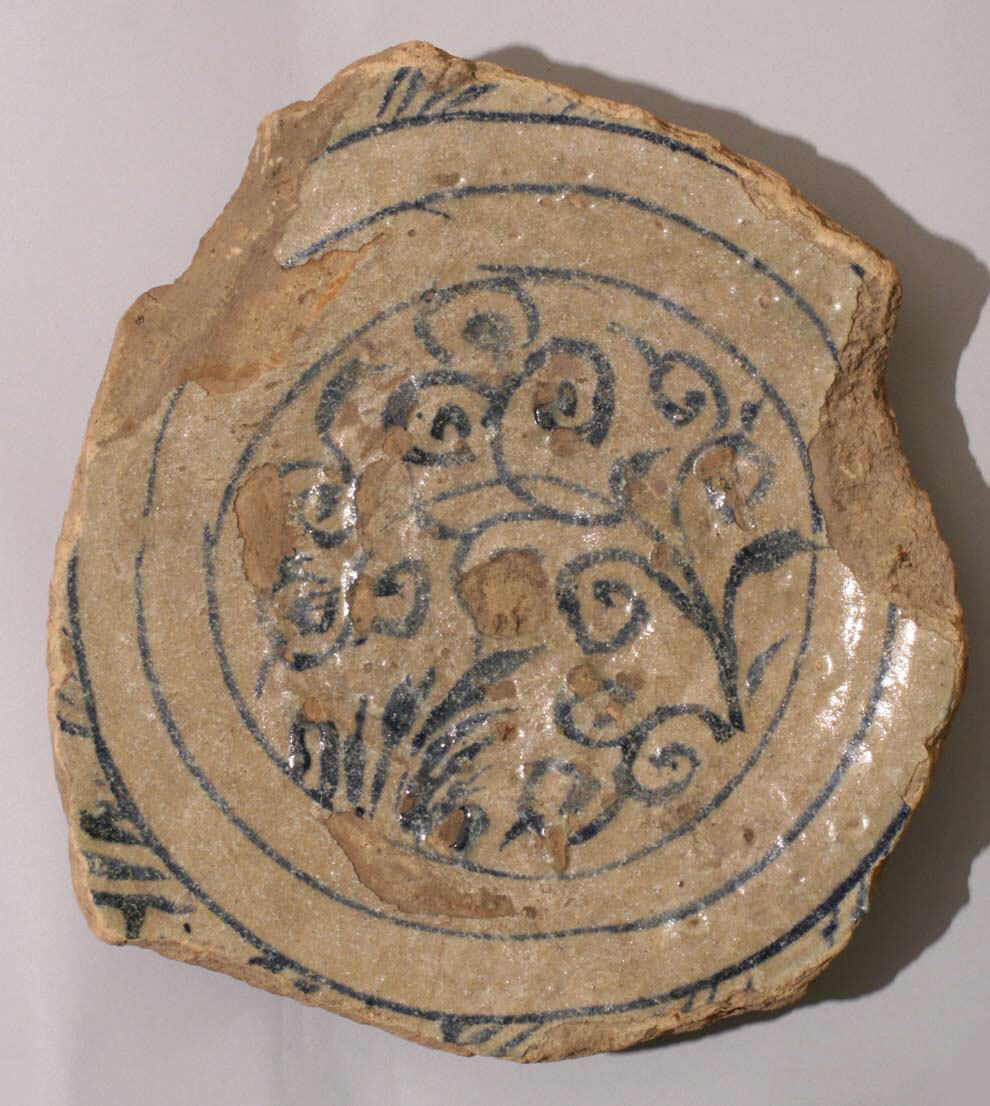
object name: ceramic fragment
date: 1401-1500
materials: earthenware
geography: egypt